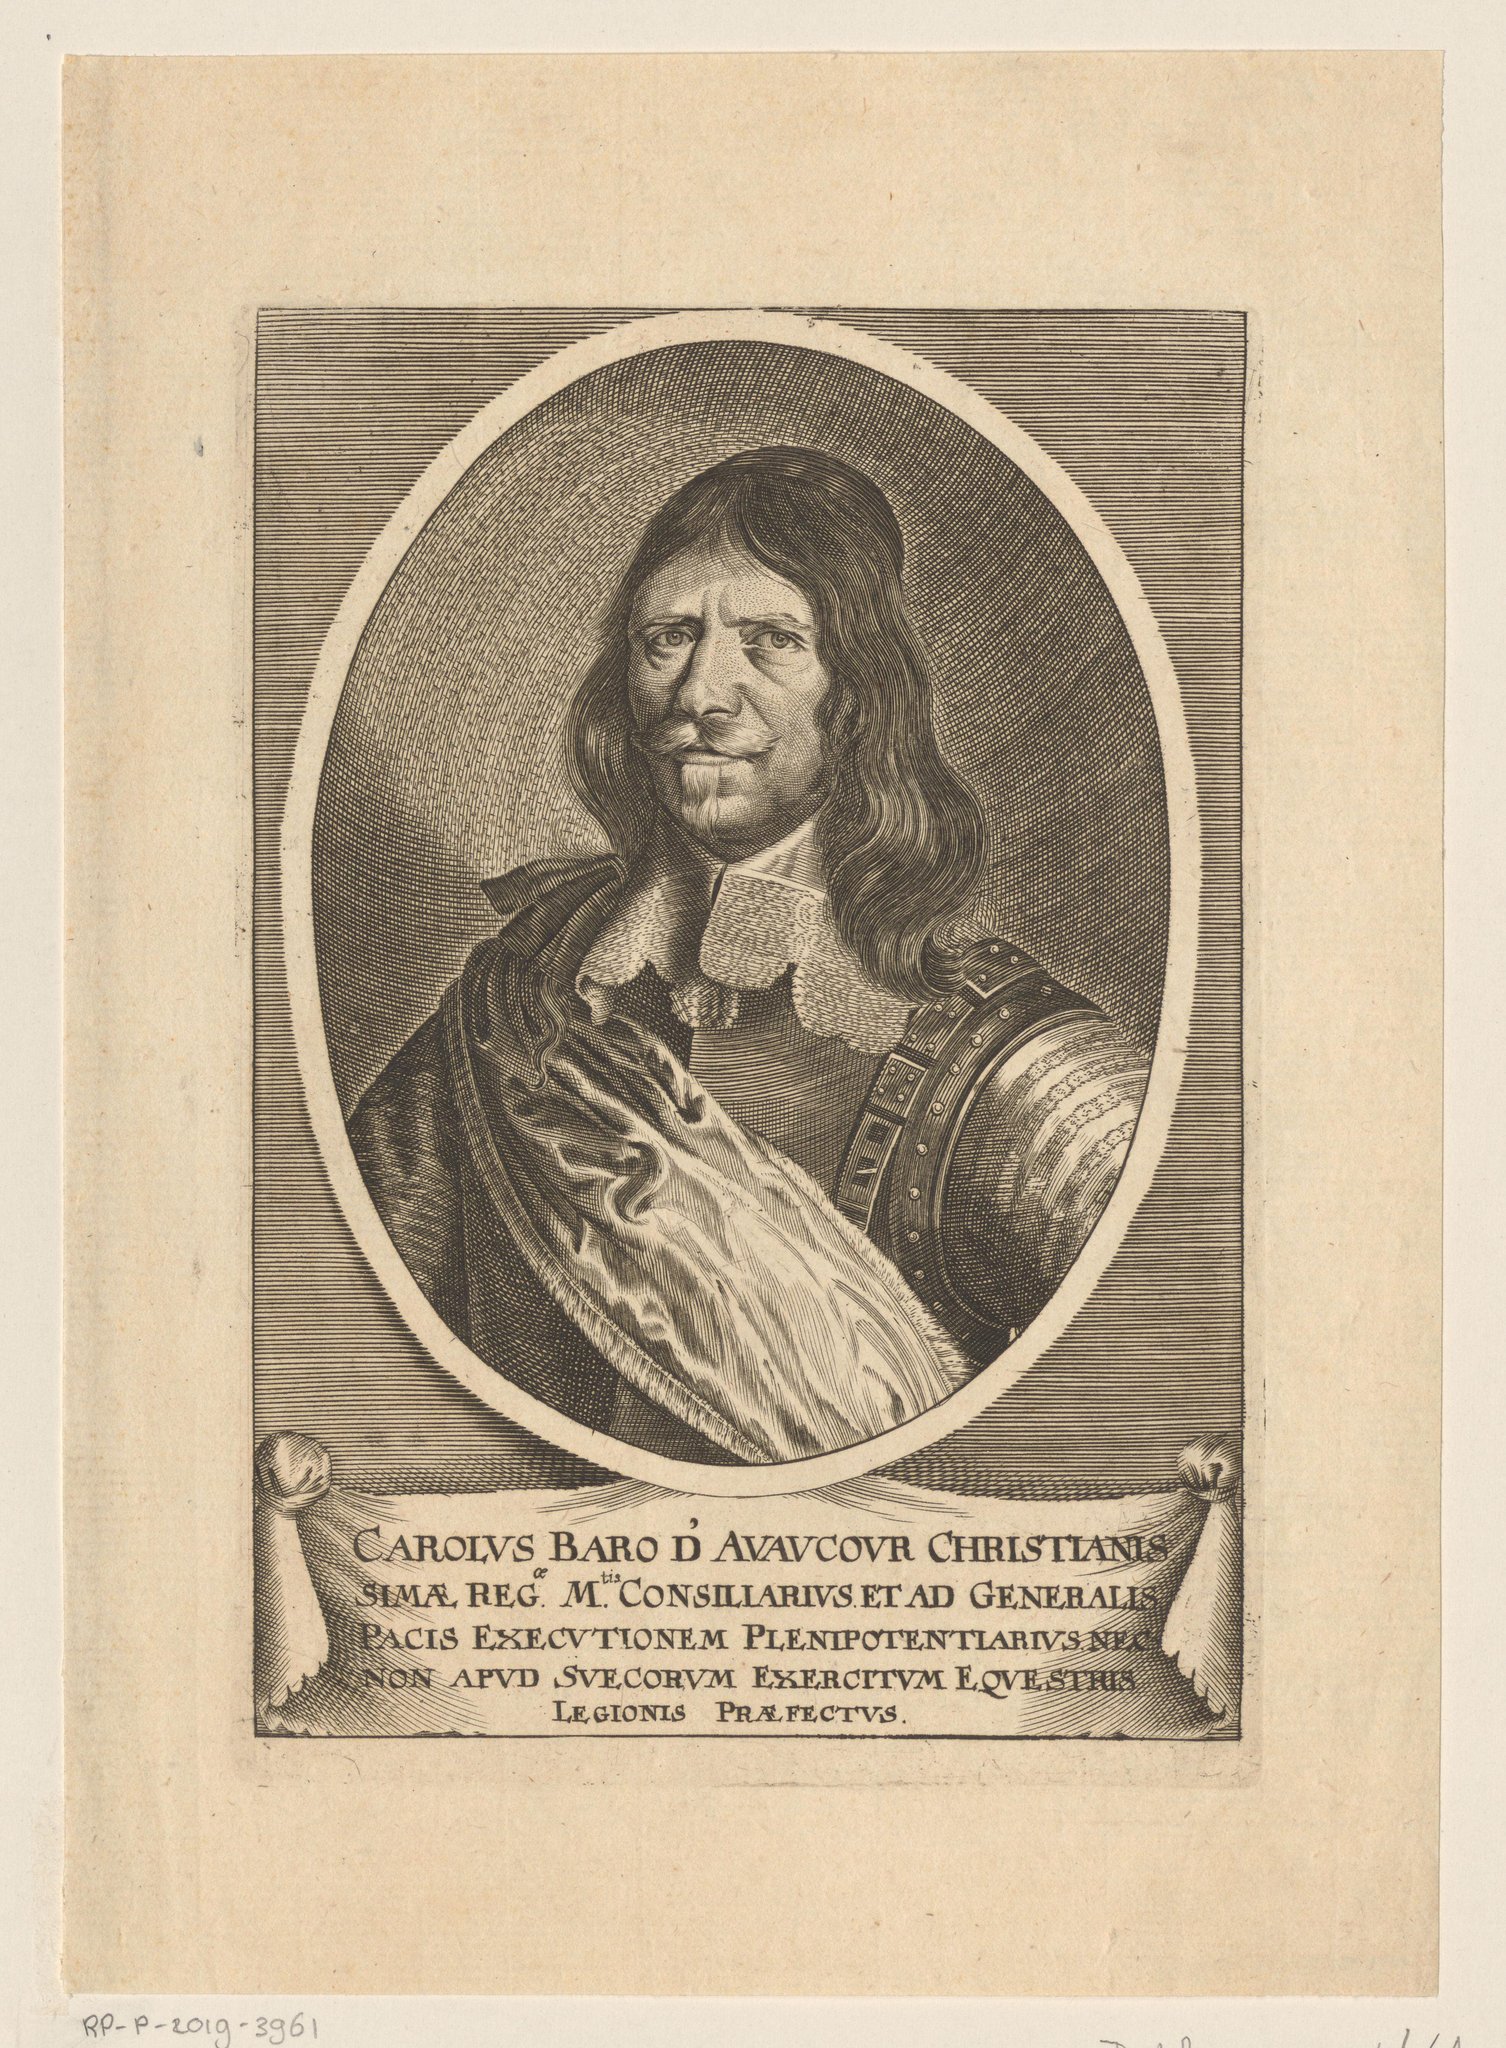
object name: print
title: Portret van Charles du Bois d'Avaugour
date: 1652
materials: paper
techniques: engraving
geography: frankfurt am main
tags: historical persons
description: Prent uit: Theatrum Europaeum. Frankfurt am Main: erven Matthäus Merian, 1652, dl. 6.